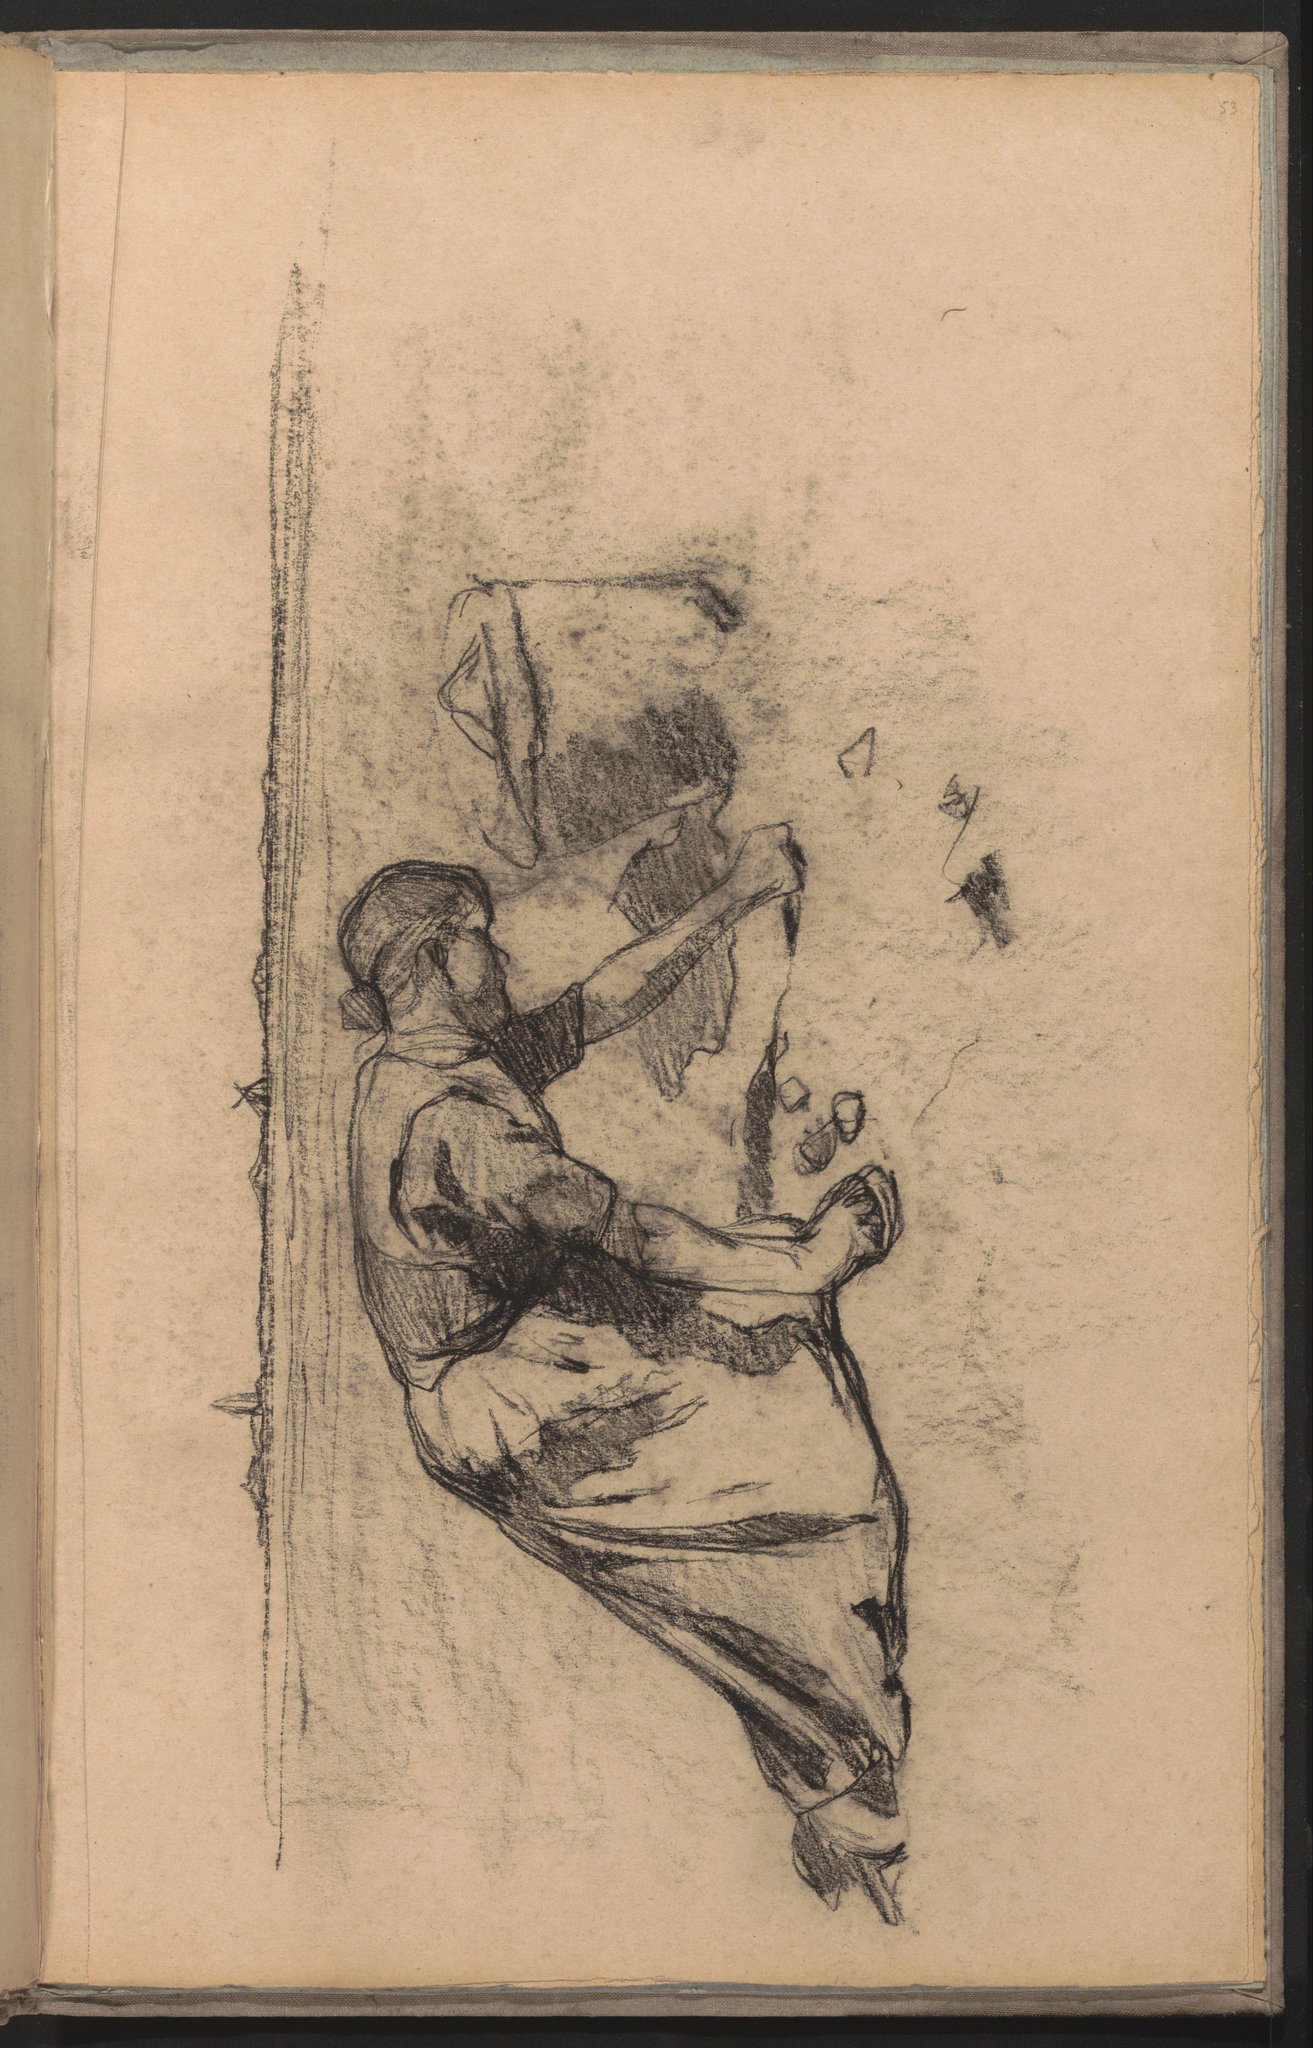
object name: sketchbook leaf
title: Aardappelrooister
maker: willem witsen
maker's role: draughtsman, painter, print maker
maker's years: 1860-1923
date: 1886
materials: chalk, paper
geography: ewijkshoeve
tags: adolescent, young woman, maiden (+ kneeling), potatoes, reaping, picking, mowing ~ harvest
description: Een jonge vrouw rooit geknield aardappelen. Voor haar een mand en in de verte bebouwing. Pagina 53 uit een schetsboek met 38 bladen betekend rond de Ewijkshoeve.